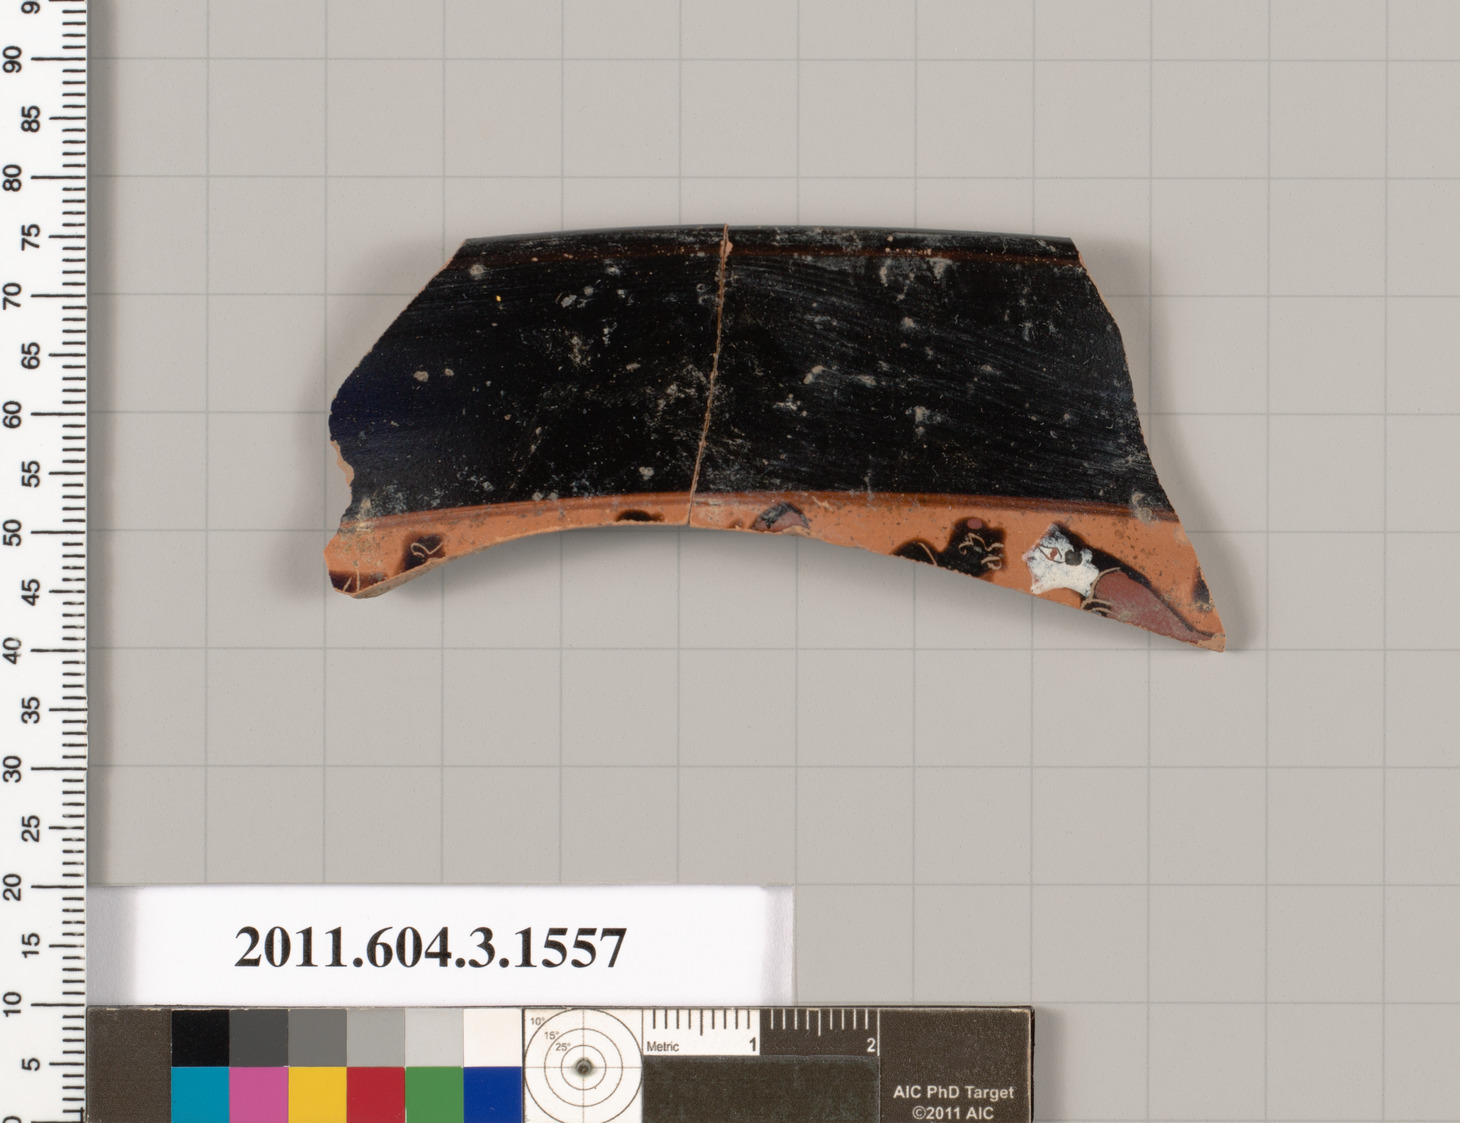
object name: kylix fragment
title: Terracotta rim fragment of a kylix: Band cup (drinking cup)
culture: greek, attic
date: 550-526 BCE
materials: terracotta